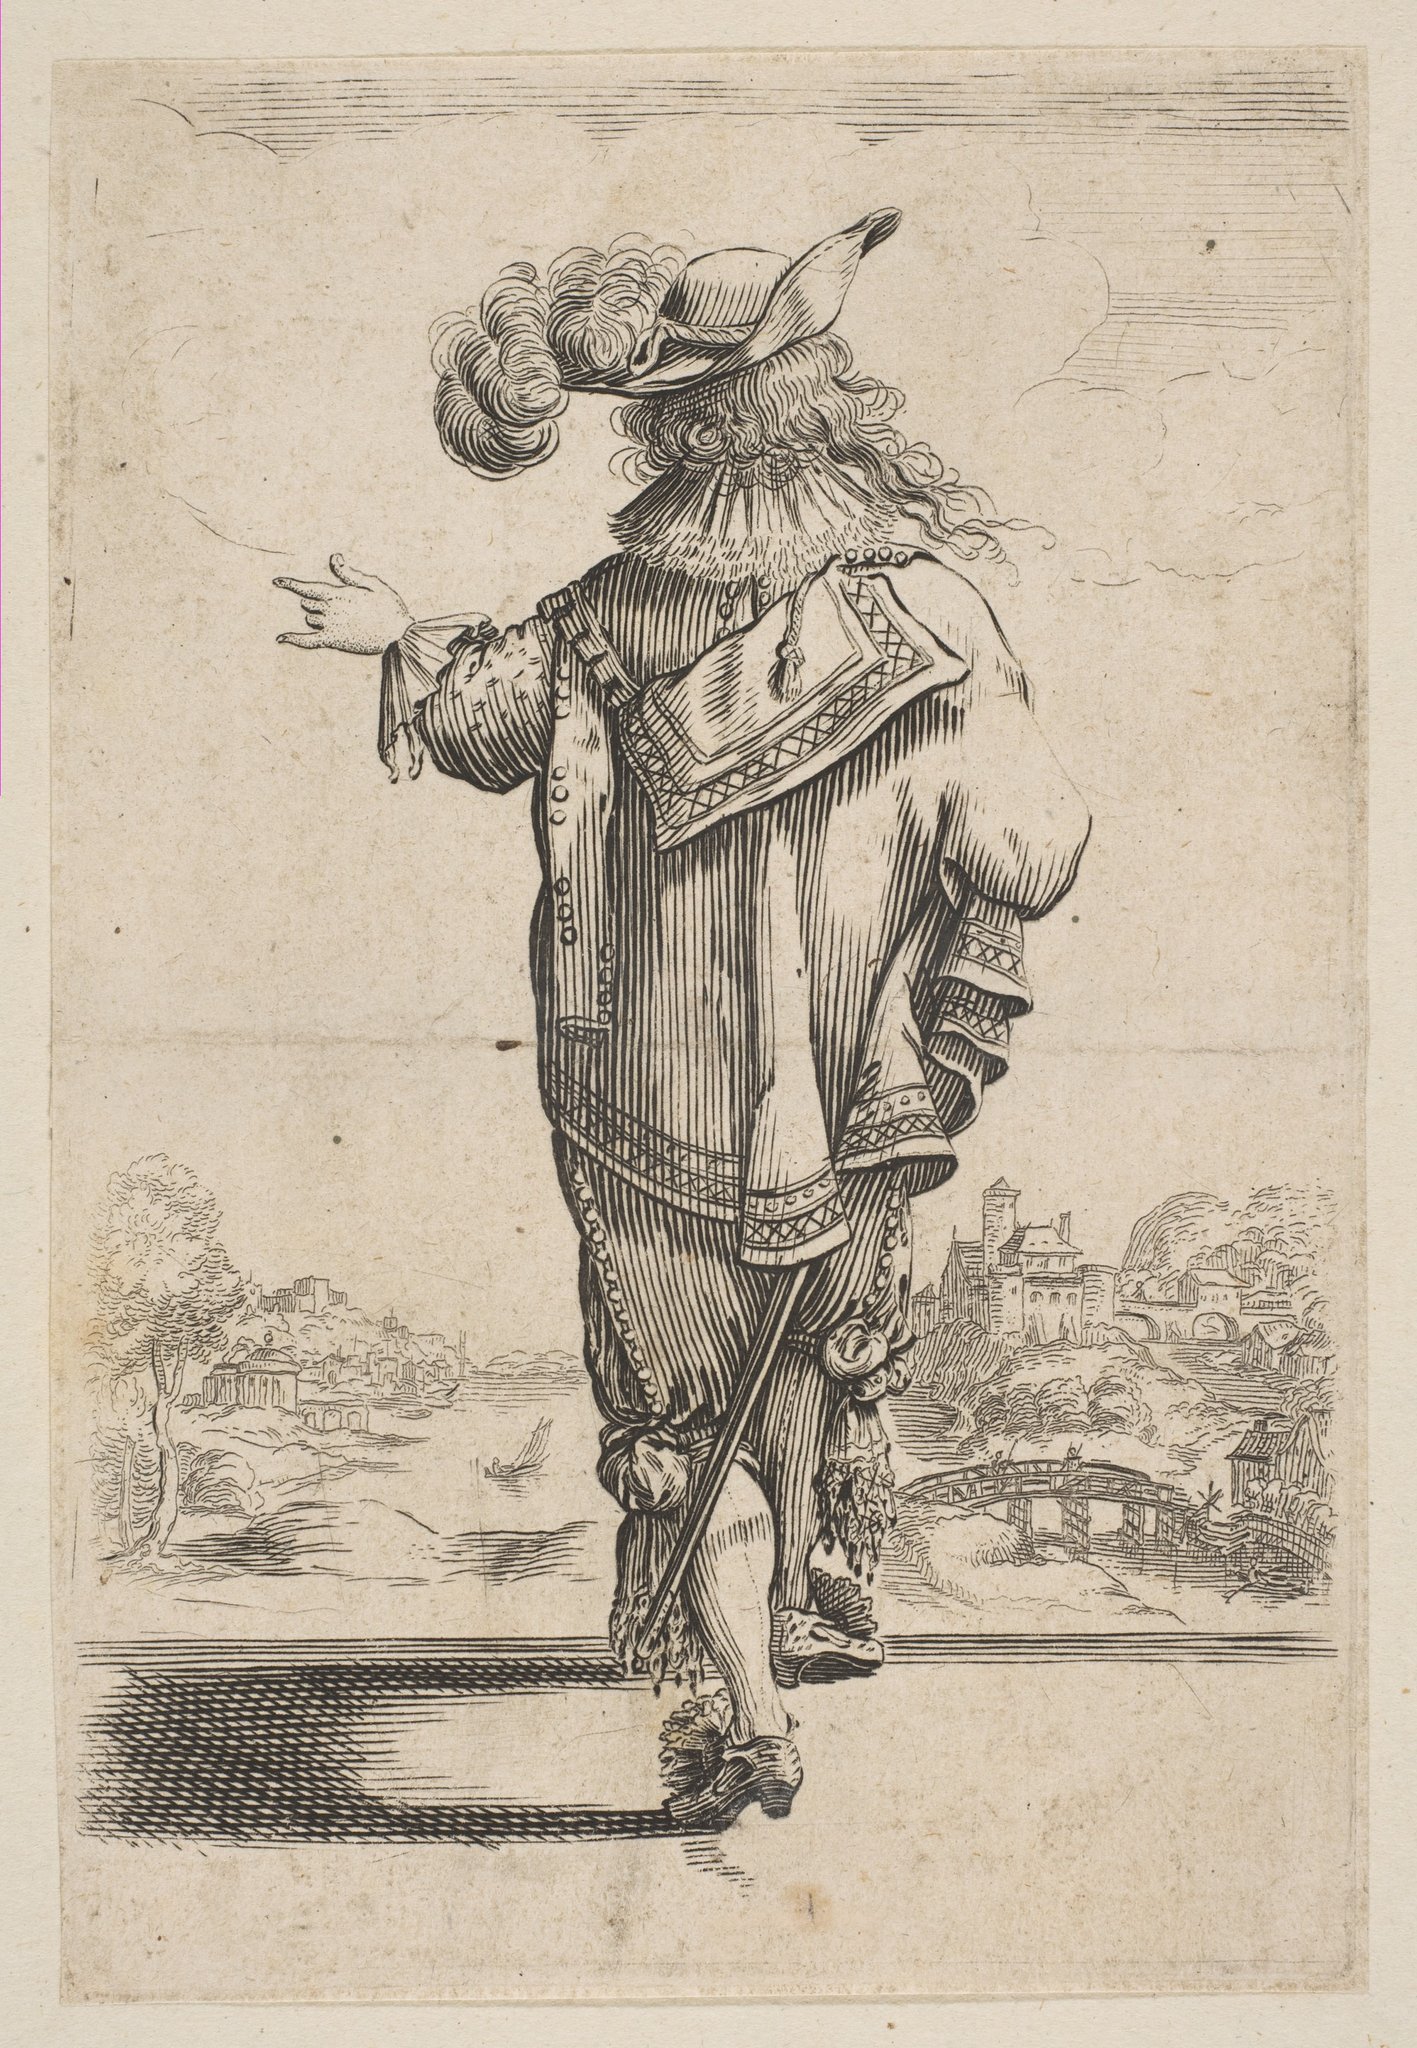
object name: print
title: Gentleman Seen from the Back Indicating a Landscape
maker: anonymous, french, 17th century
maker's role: artist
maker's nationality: french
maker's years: 1600-1700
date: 1629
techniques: etching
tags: men